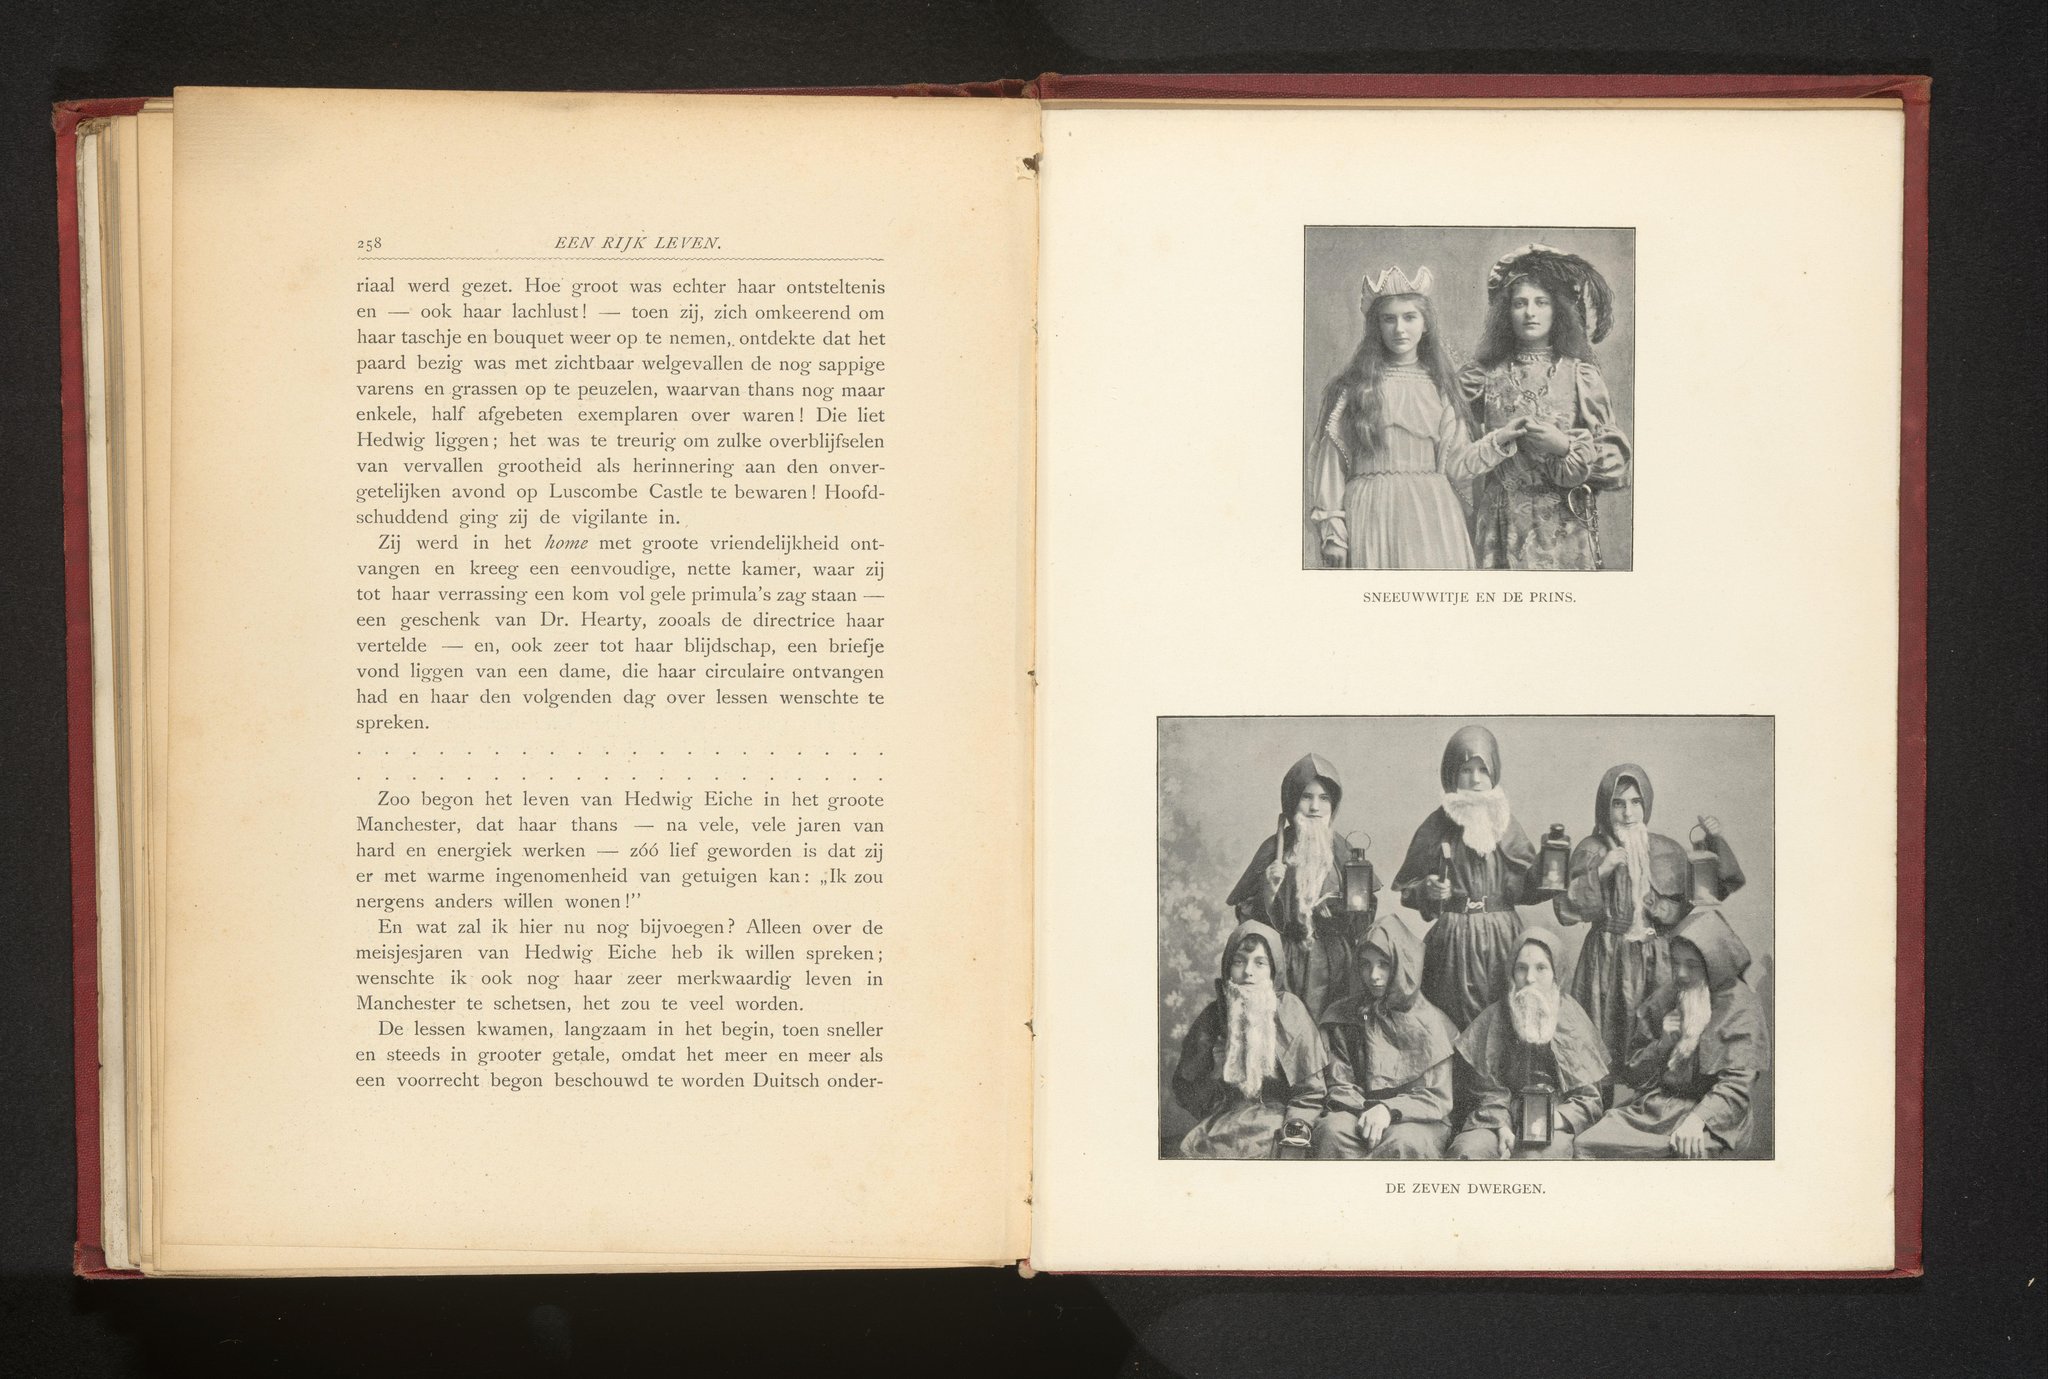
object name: page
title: De zeven dwergen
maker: Anonymous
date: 1901-1906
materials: paper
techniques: autotype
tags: actor (on the stage)